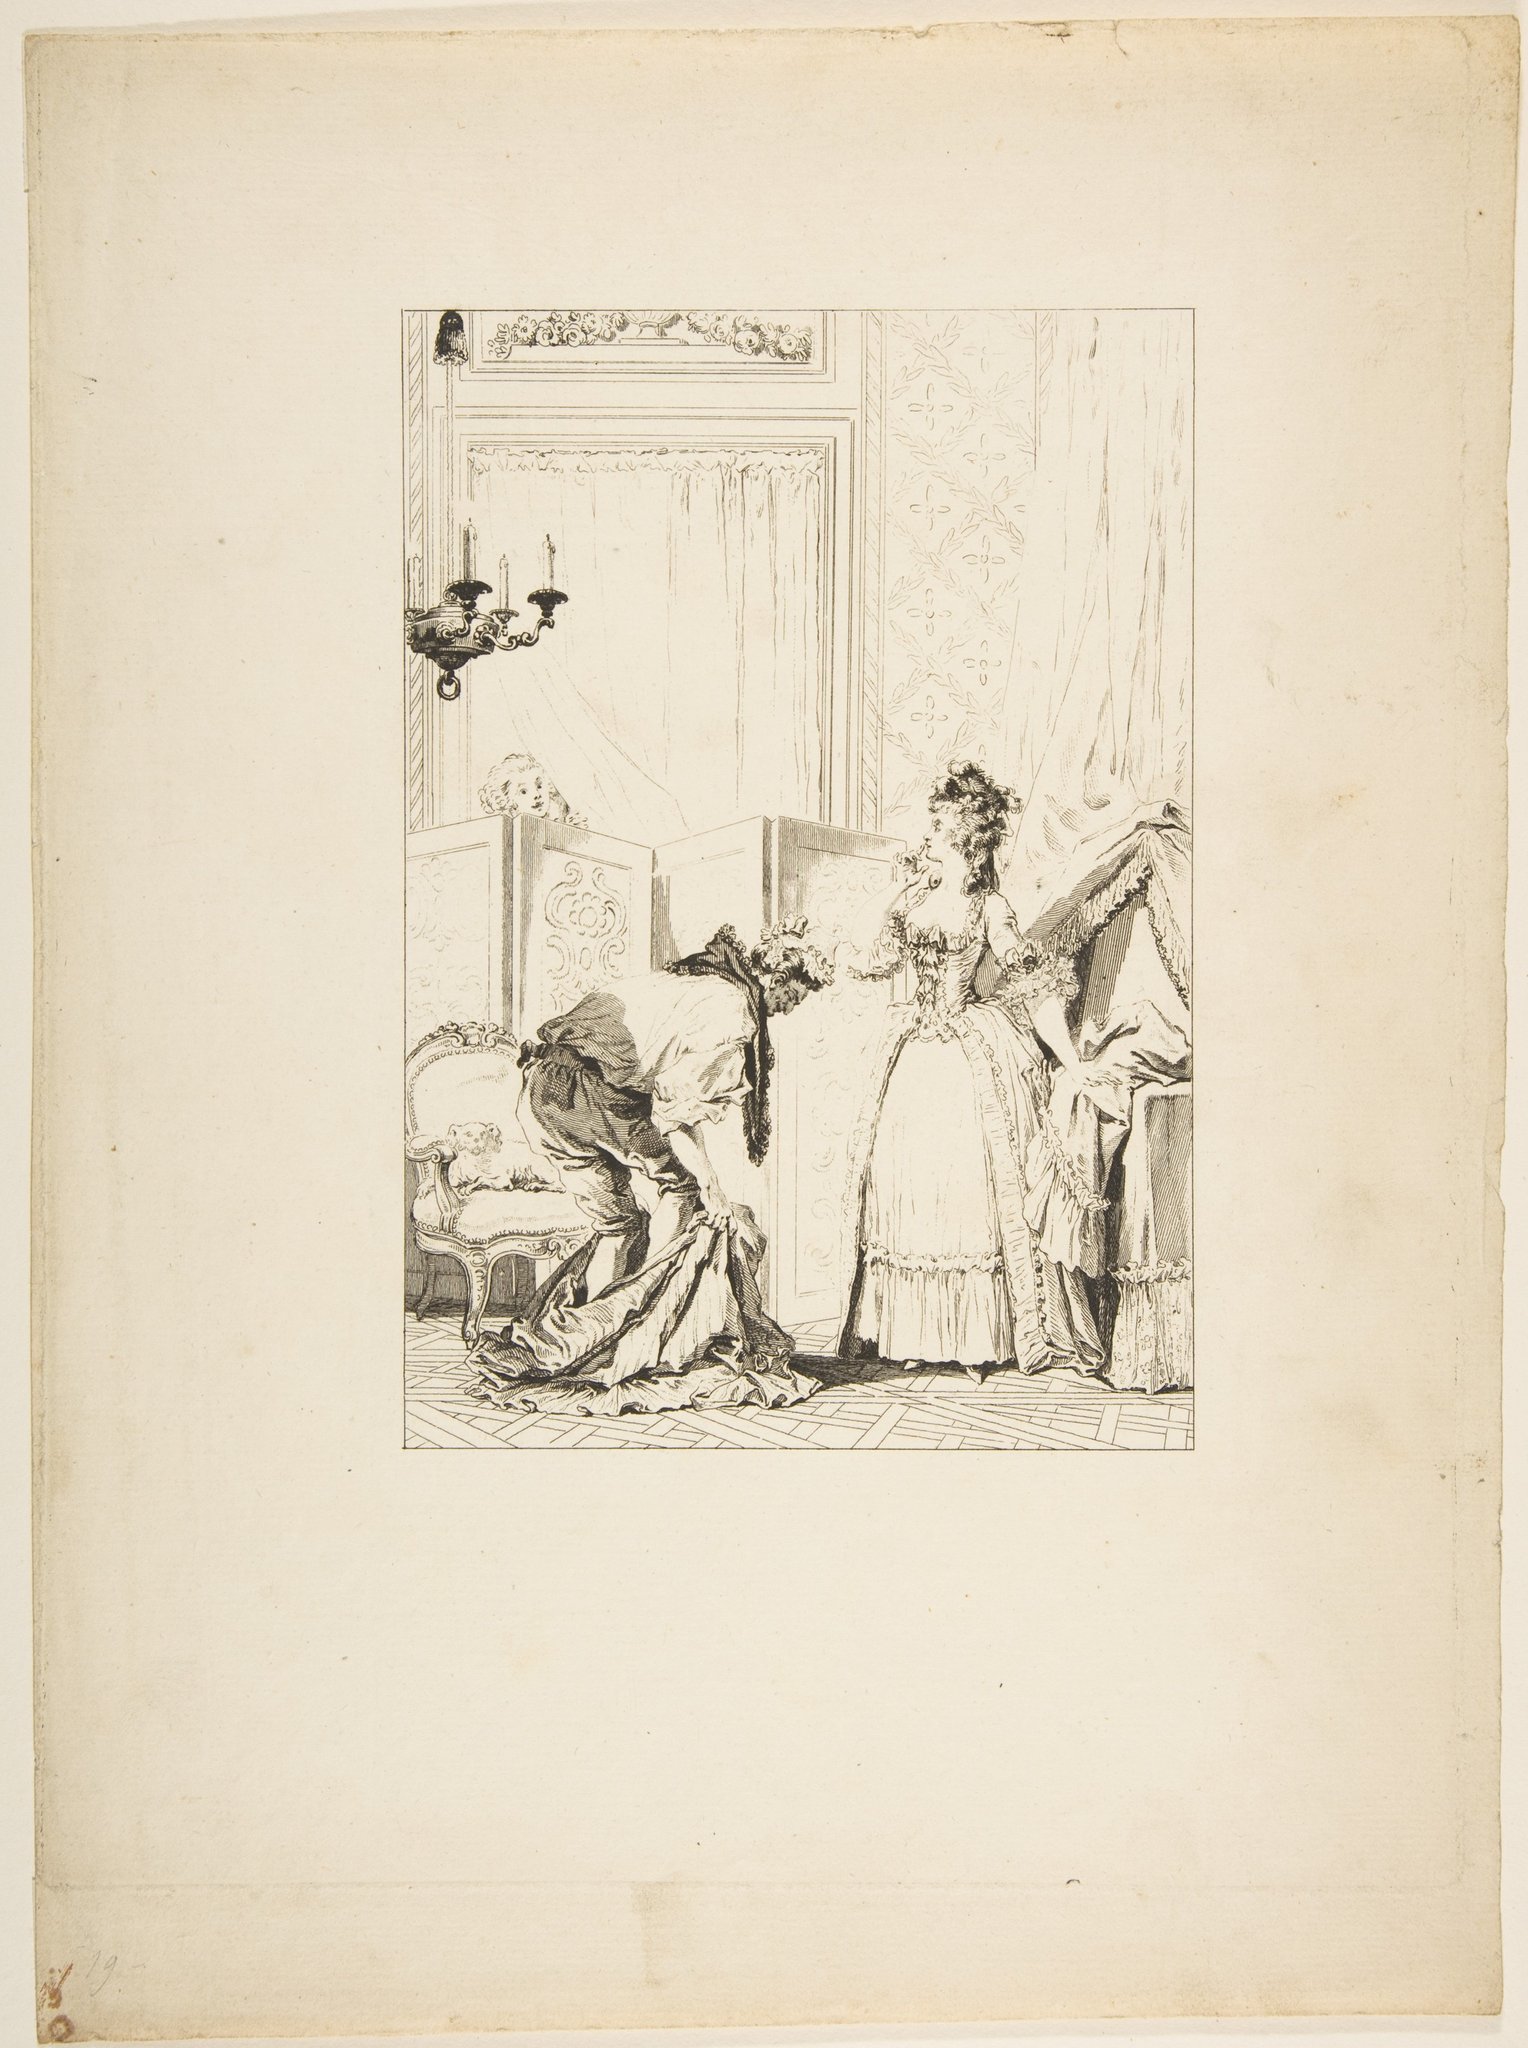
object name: print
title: Le Cocu battu et content, from "Contes et nouvelles en vers par Jean de La Fontaine. A Paris, de l'imprimerie de P. Didot, l'an III de la République, 1795"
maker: jean-louis delignon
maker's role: artist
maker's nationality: french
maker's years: 1755-1804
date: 1795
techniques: engraving, etching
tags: men,women,dressing